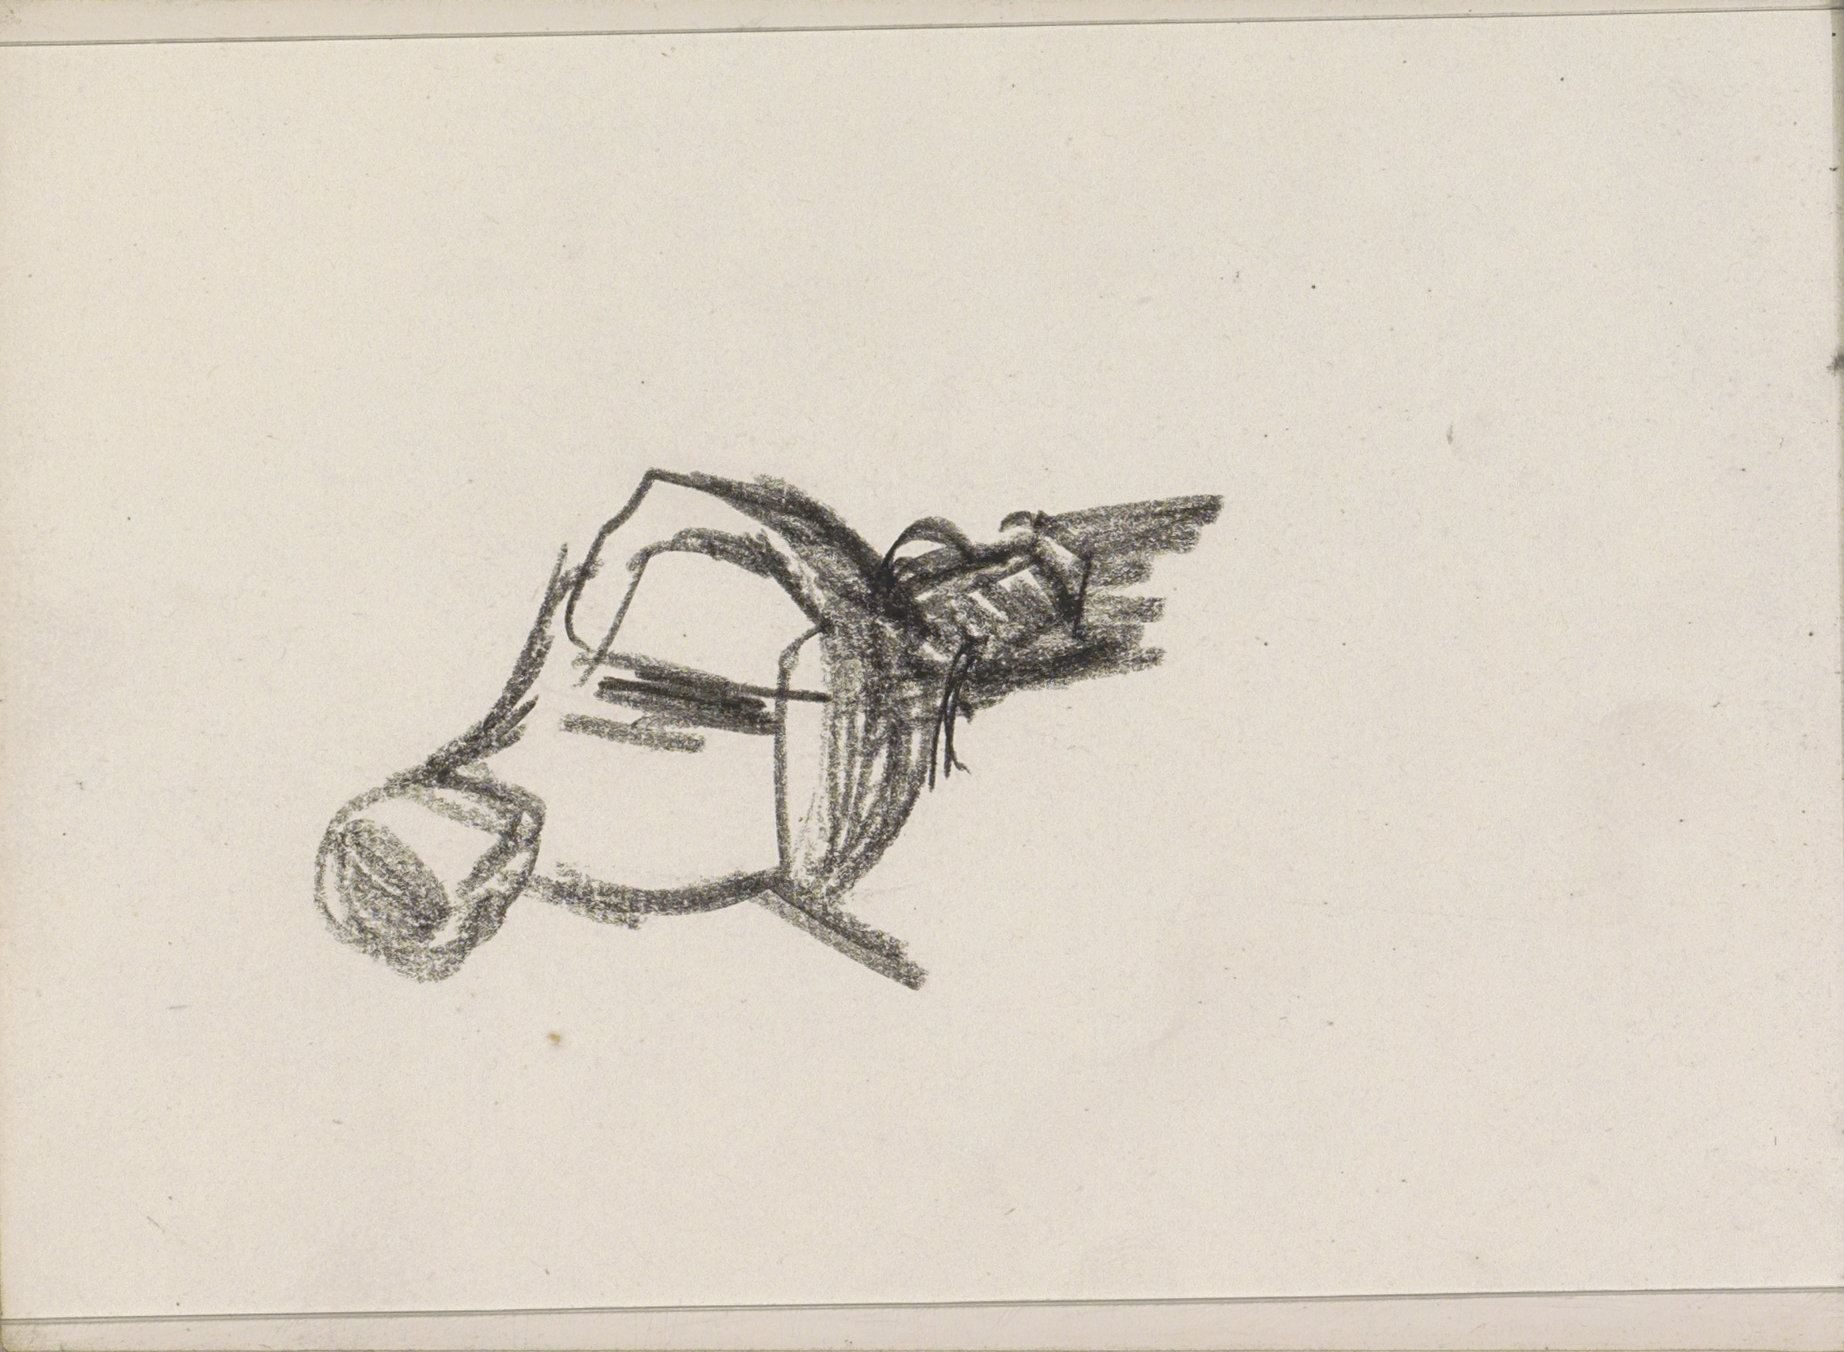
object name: sketchbook leaf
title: Vrouw, in profiel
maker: isaac israels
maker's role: draughtsman, painter, print maker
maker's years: 1865-1934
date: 1886-1903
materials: chalk, paper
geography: amsterdam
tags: adult woman (+ sideview, profile)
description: Ze is mogelijk met haar schort bezig. Pagina 42 uit schetsboek XLVII met 52 pagina's.